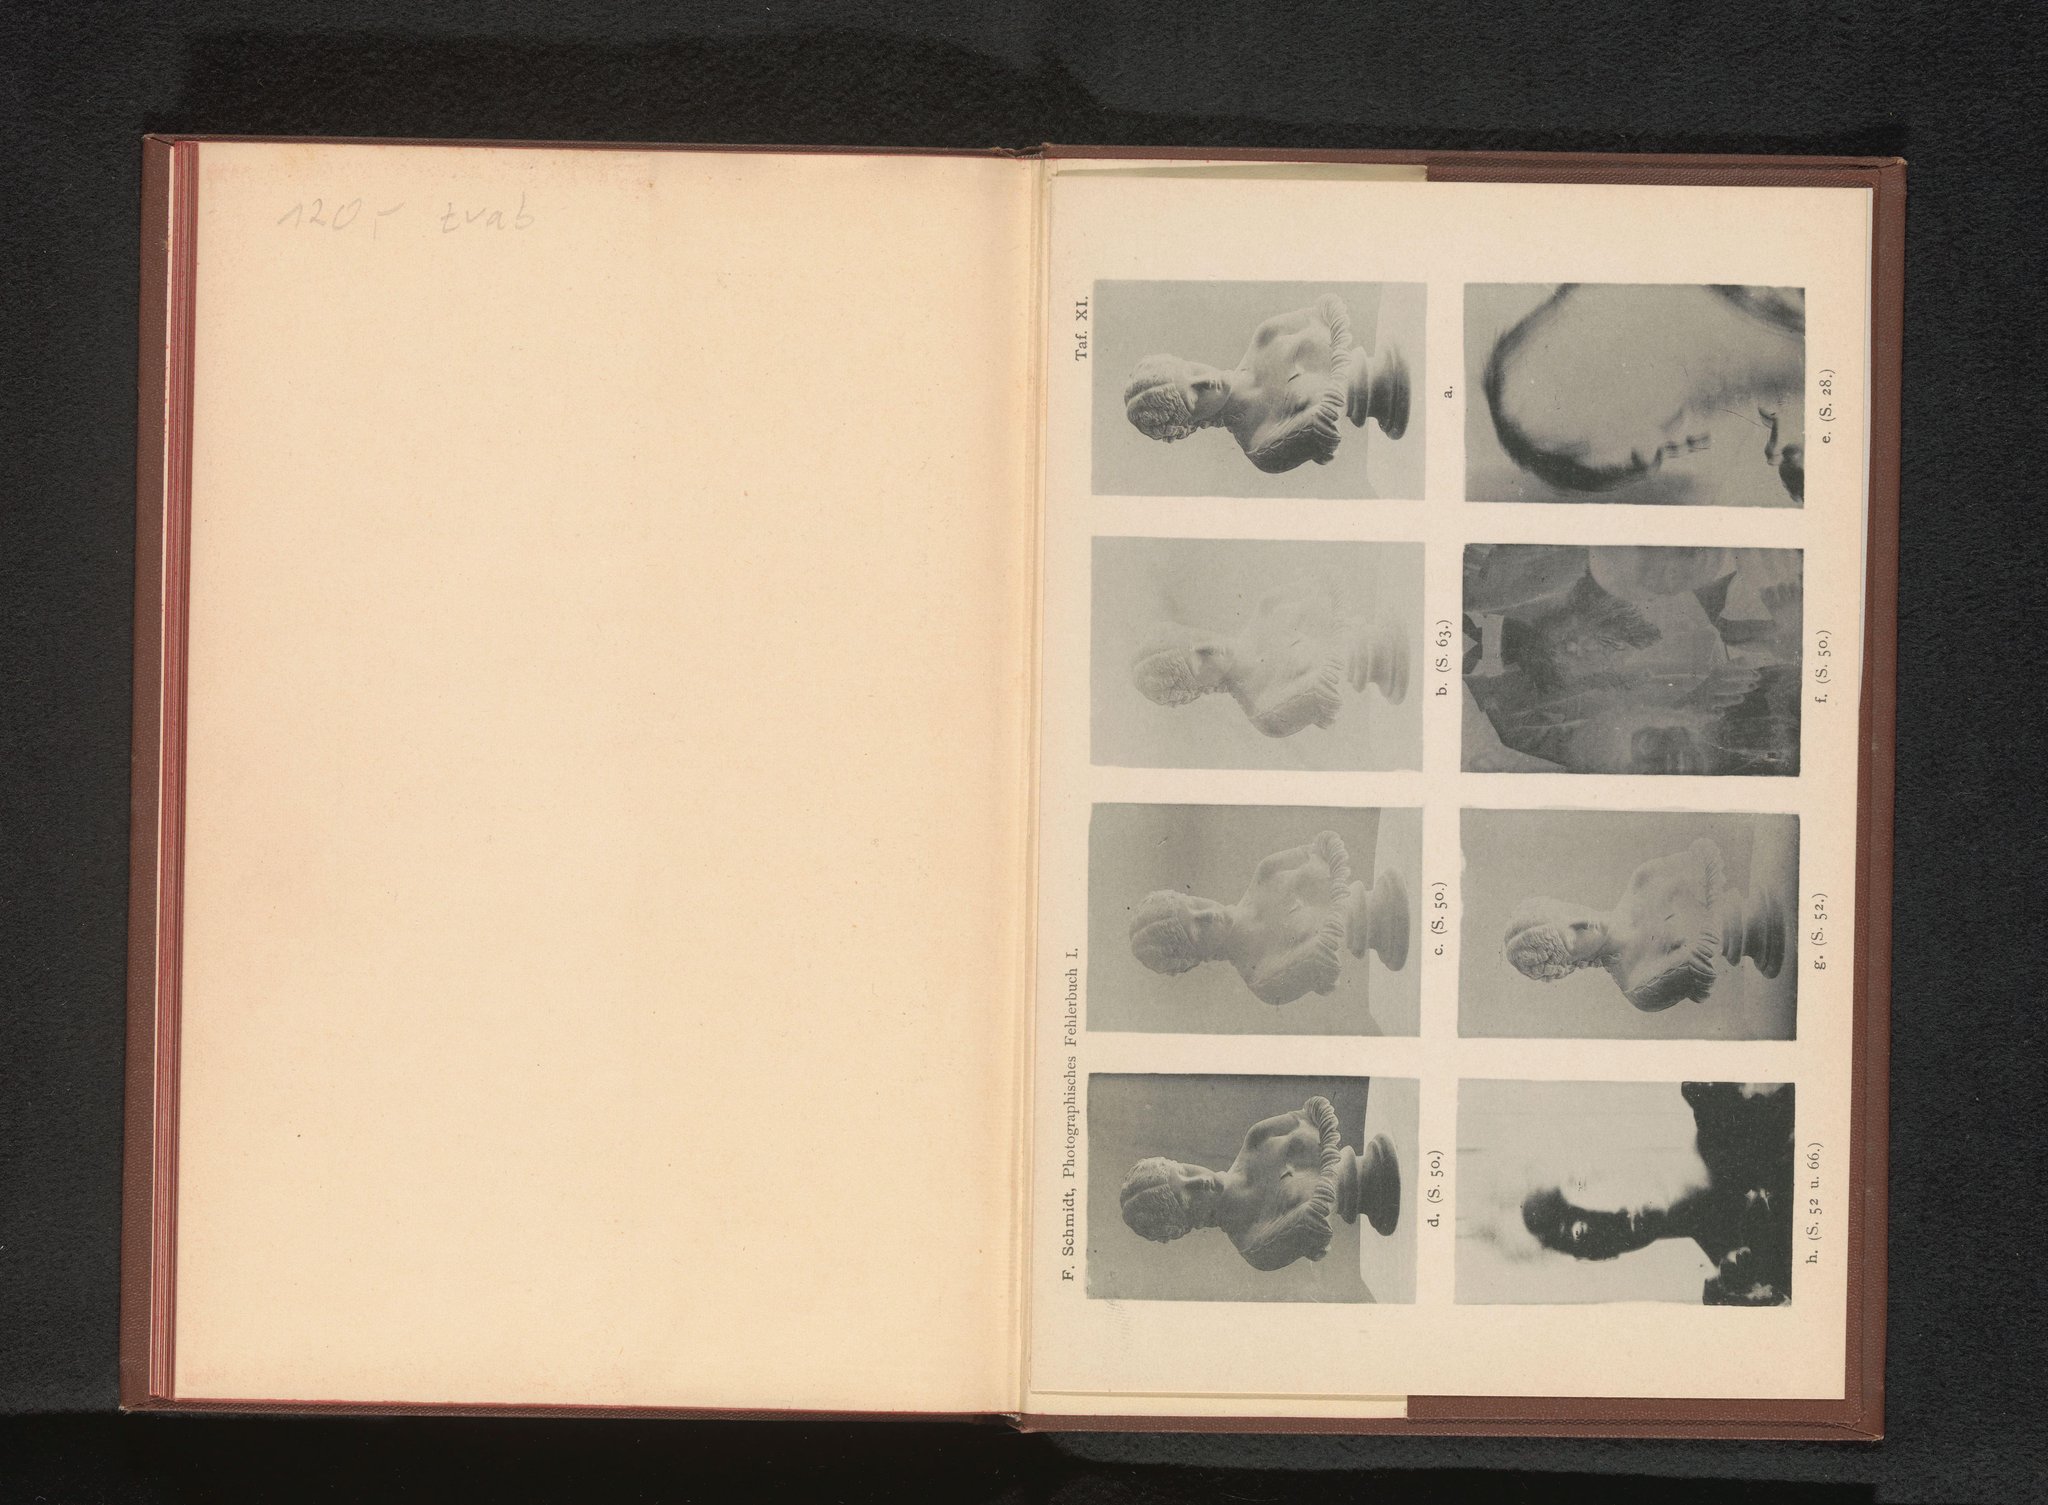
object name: page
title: Acht voorbeelden van belichtingsstudies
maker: Anonymous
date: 1890-1895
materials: paper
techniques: photograph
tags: piece of sculpture, reproduction of a piece of sculpture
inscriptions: number: ‘Taf. XI.’, inscription: ‘d. (S. 50.) c. (S. 50.) b. (S. 63.) a./ h. (S. 52 u. 66.) g. (S. 52.) f. (S. 50.) e. (S. 28.)’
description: Prenten op losse bladen. Bladen in insteekhoes achterin boek.